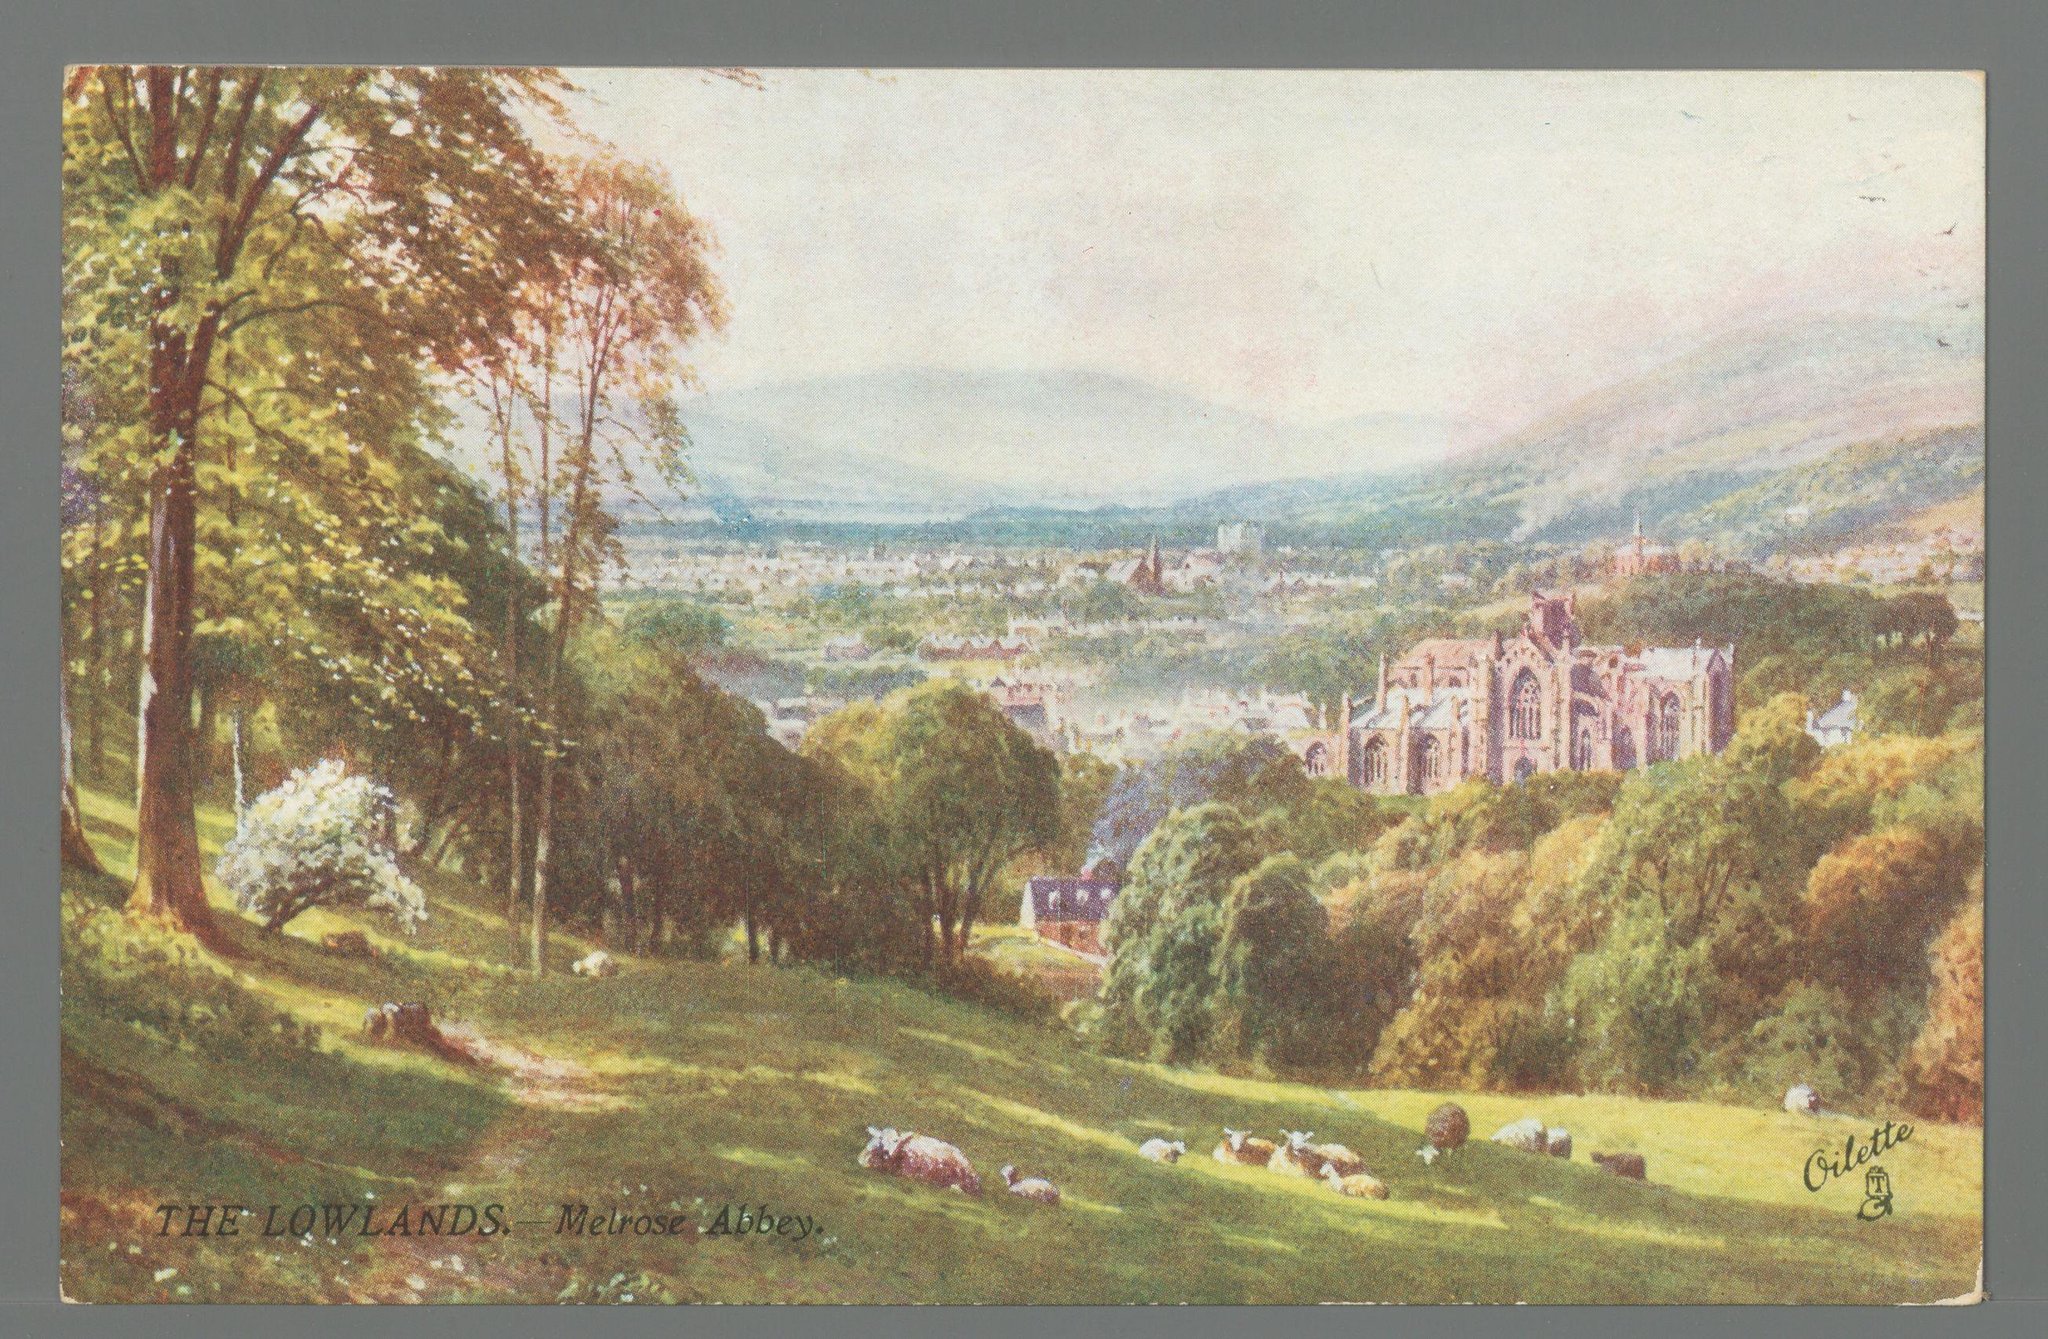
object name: reproduction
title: Oilette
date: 1906-1912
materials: cardboard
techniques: color autotype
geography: london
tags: city-view, and landscape with man-made constructions, abbey, monastery, convent ~ roman catholic church